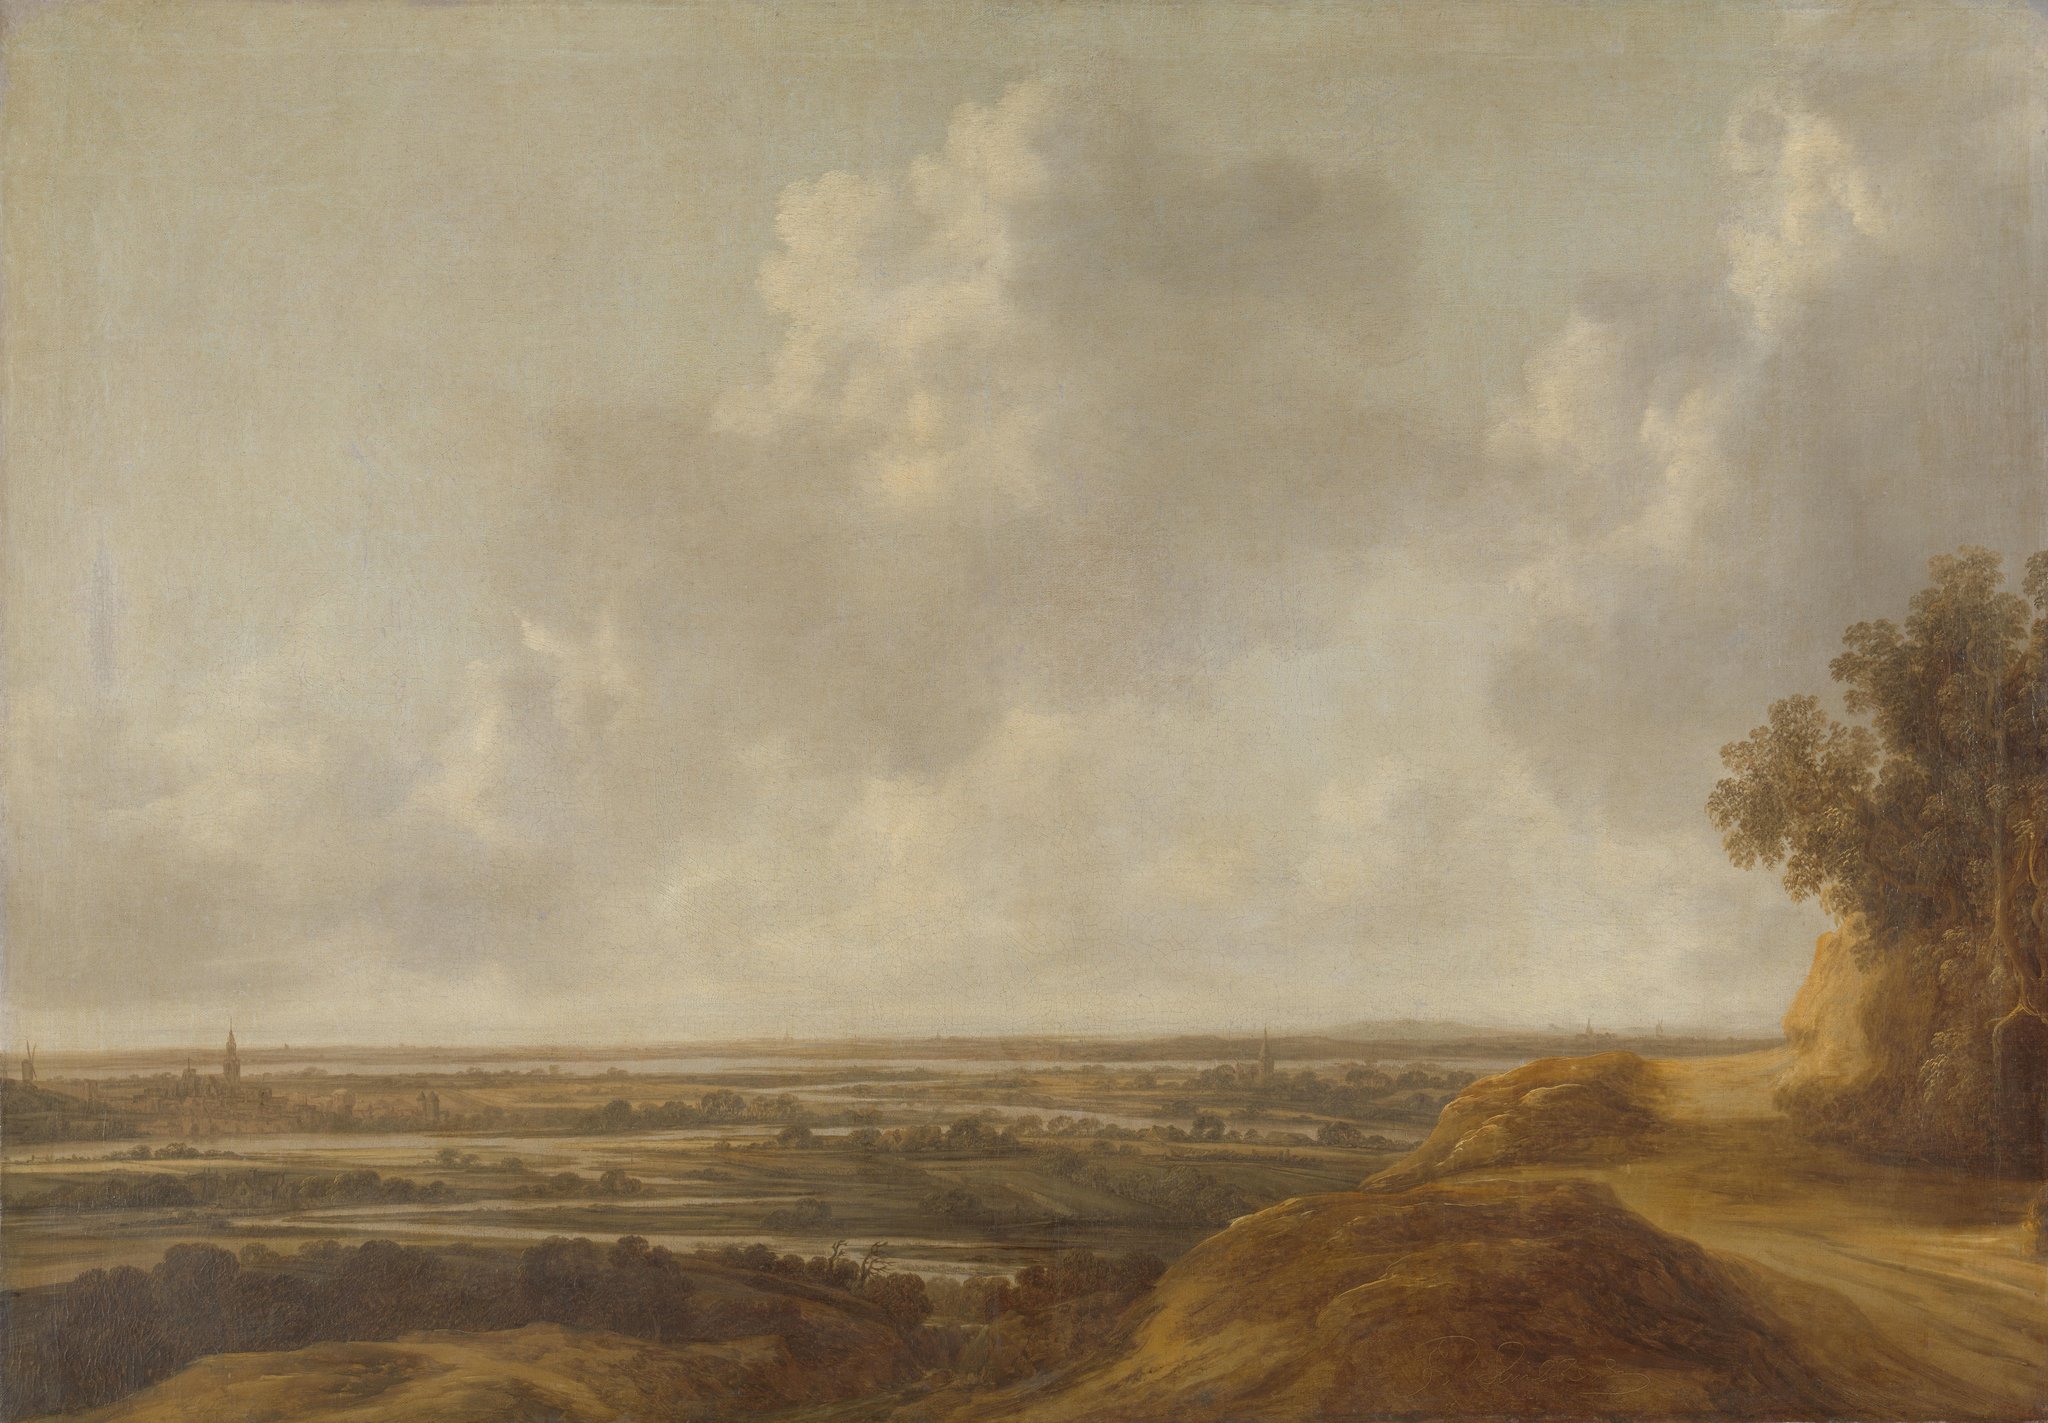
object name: painting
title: Panorama in the Countryside Around Kleve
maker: françois van knibbergen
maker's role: draughtsman, painter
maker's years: 1596-1665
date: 1655-1665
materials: canvas, oil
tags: landscapes in the temperate zone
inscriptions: signature, lower right: ‘F. Knibbergen’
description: Panoramisch landschap. Rivierlandschap, op de voorgrond enkele figuren op een heuveltje, in de verte een rivier met talrijke boten.